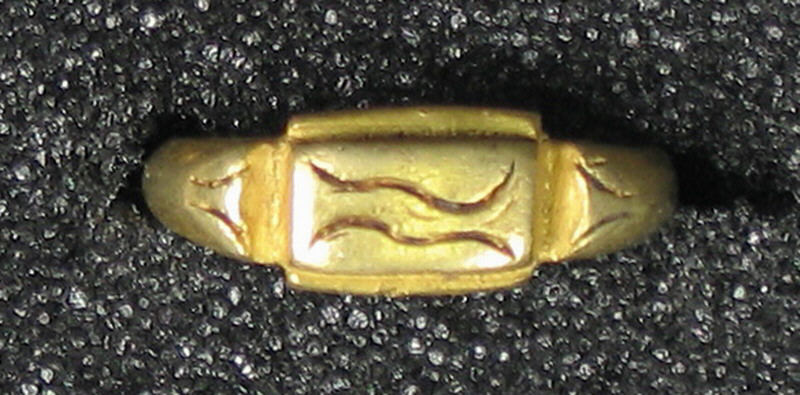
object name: ring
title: Ring with Rectangular Bezel, Wavy Line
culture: indonesian, central java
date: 701-1200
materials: gold